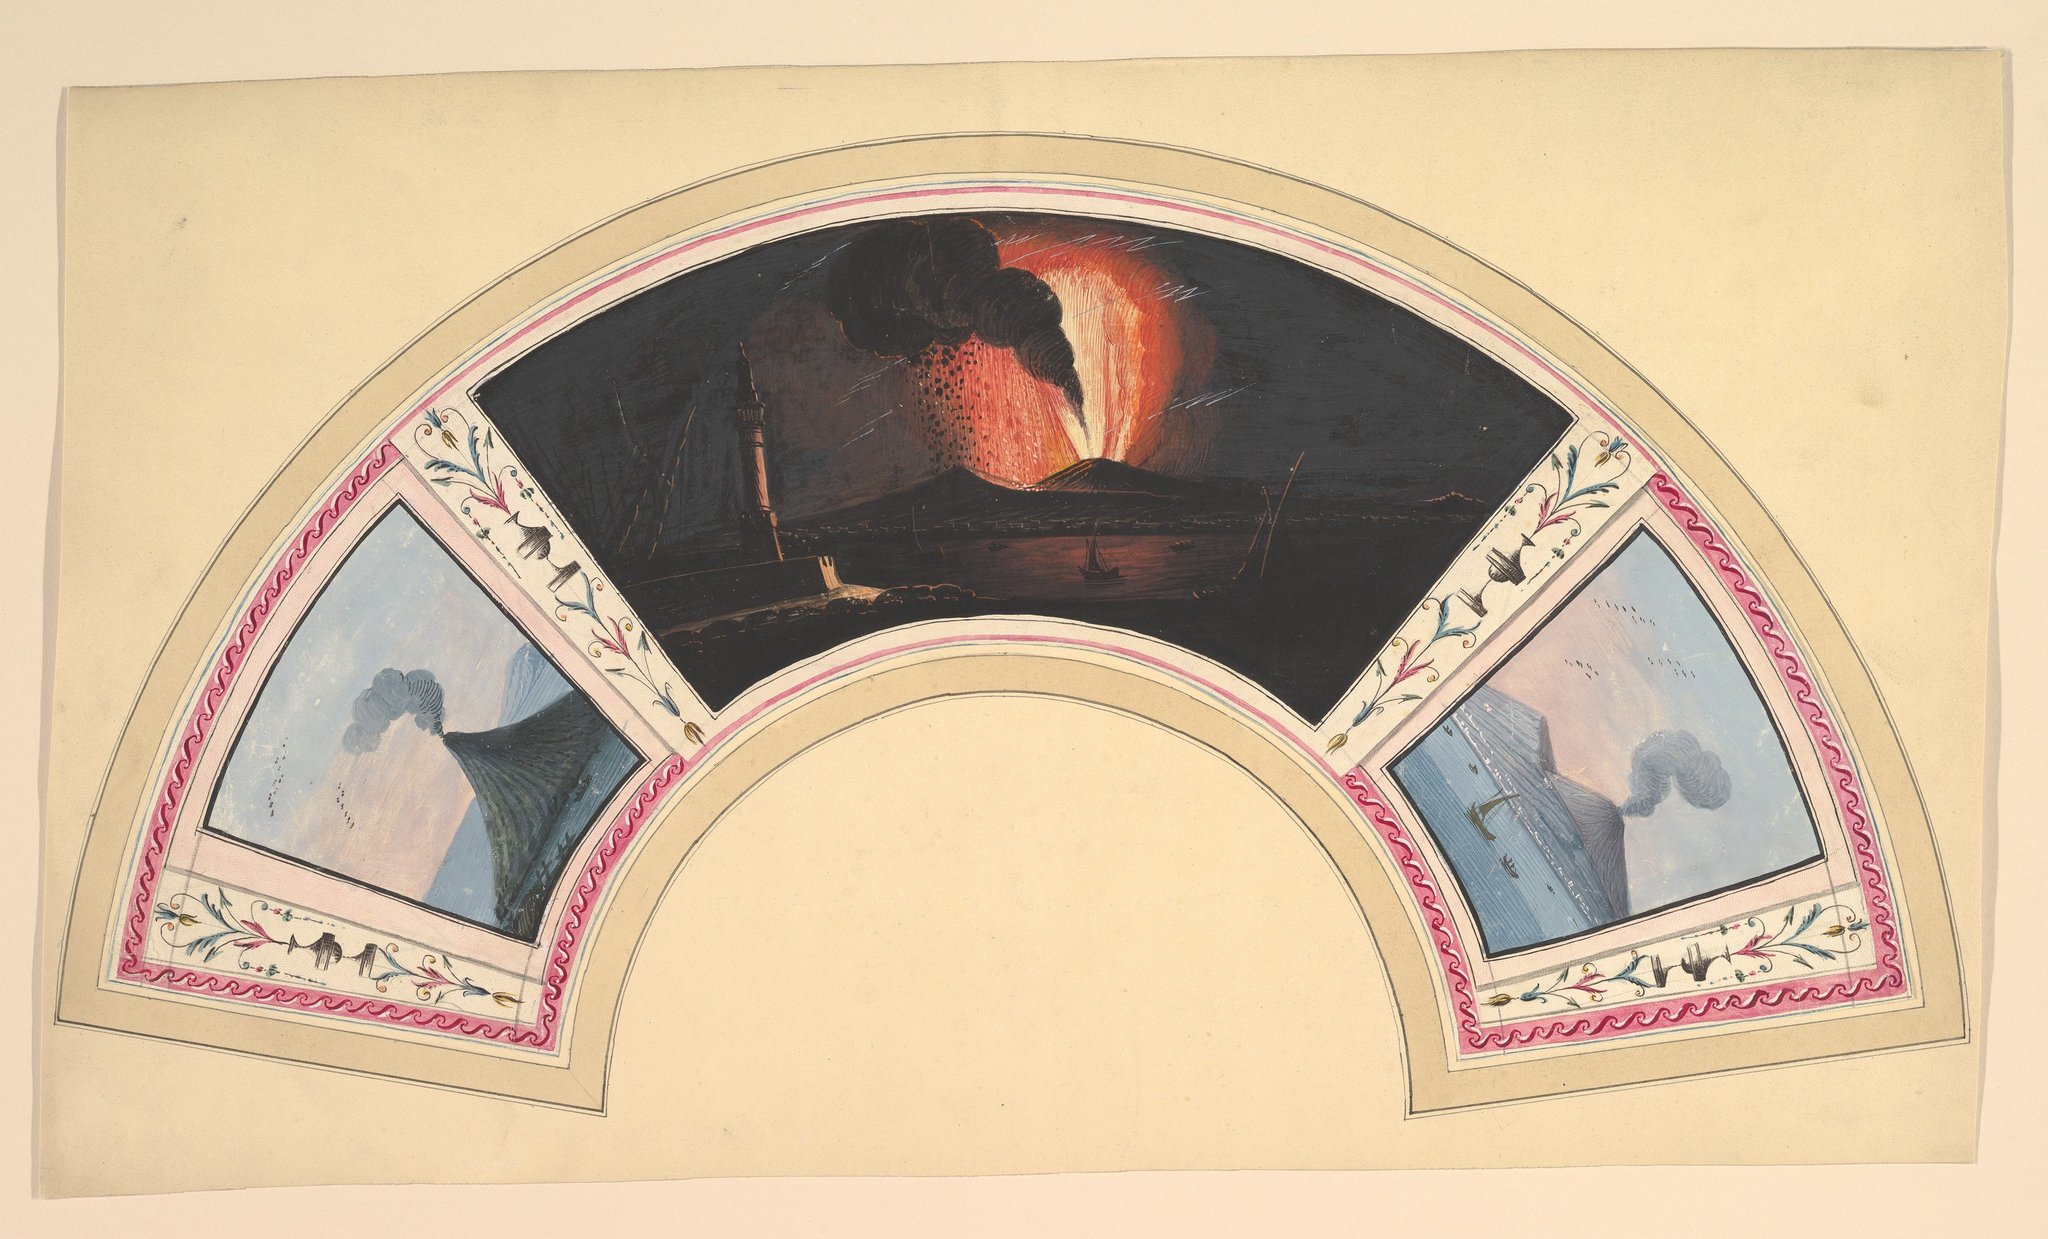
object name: drawing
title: Hand-painted Fan with Three Views of Mount Vesuvius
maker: anonymous, italian, 18th century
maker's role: artist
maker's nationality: italian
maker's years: 1700-1800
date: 1770-1780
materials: parchment, watercolor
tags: fans,volcanoes